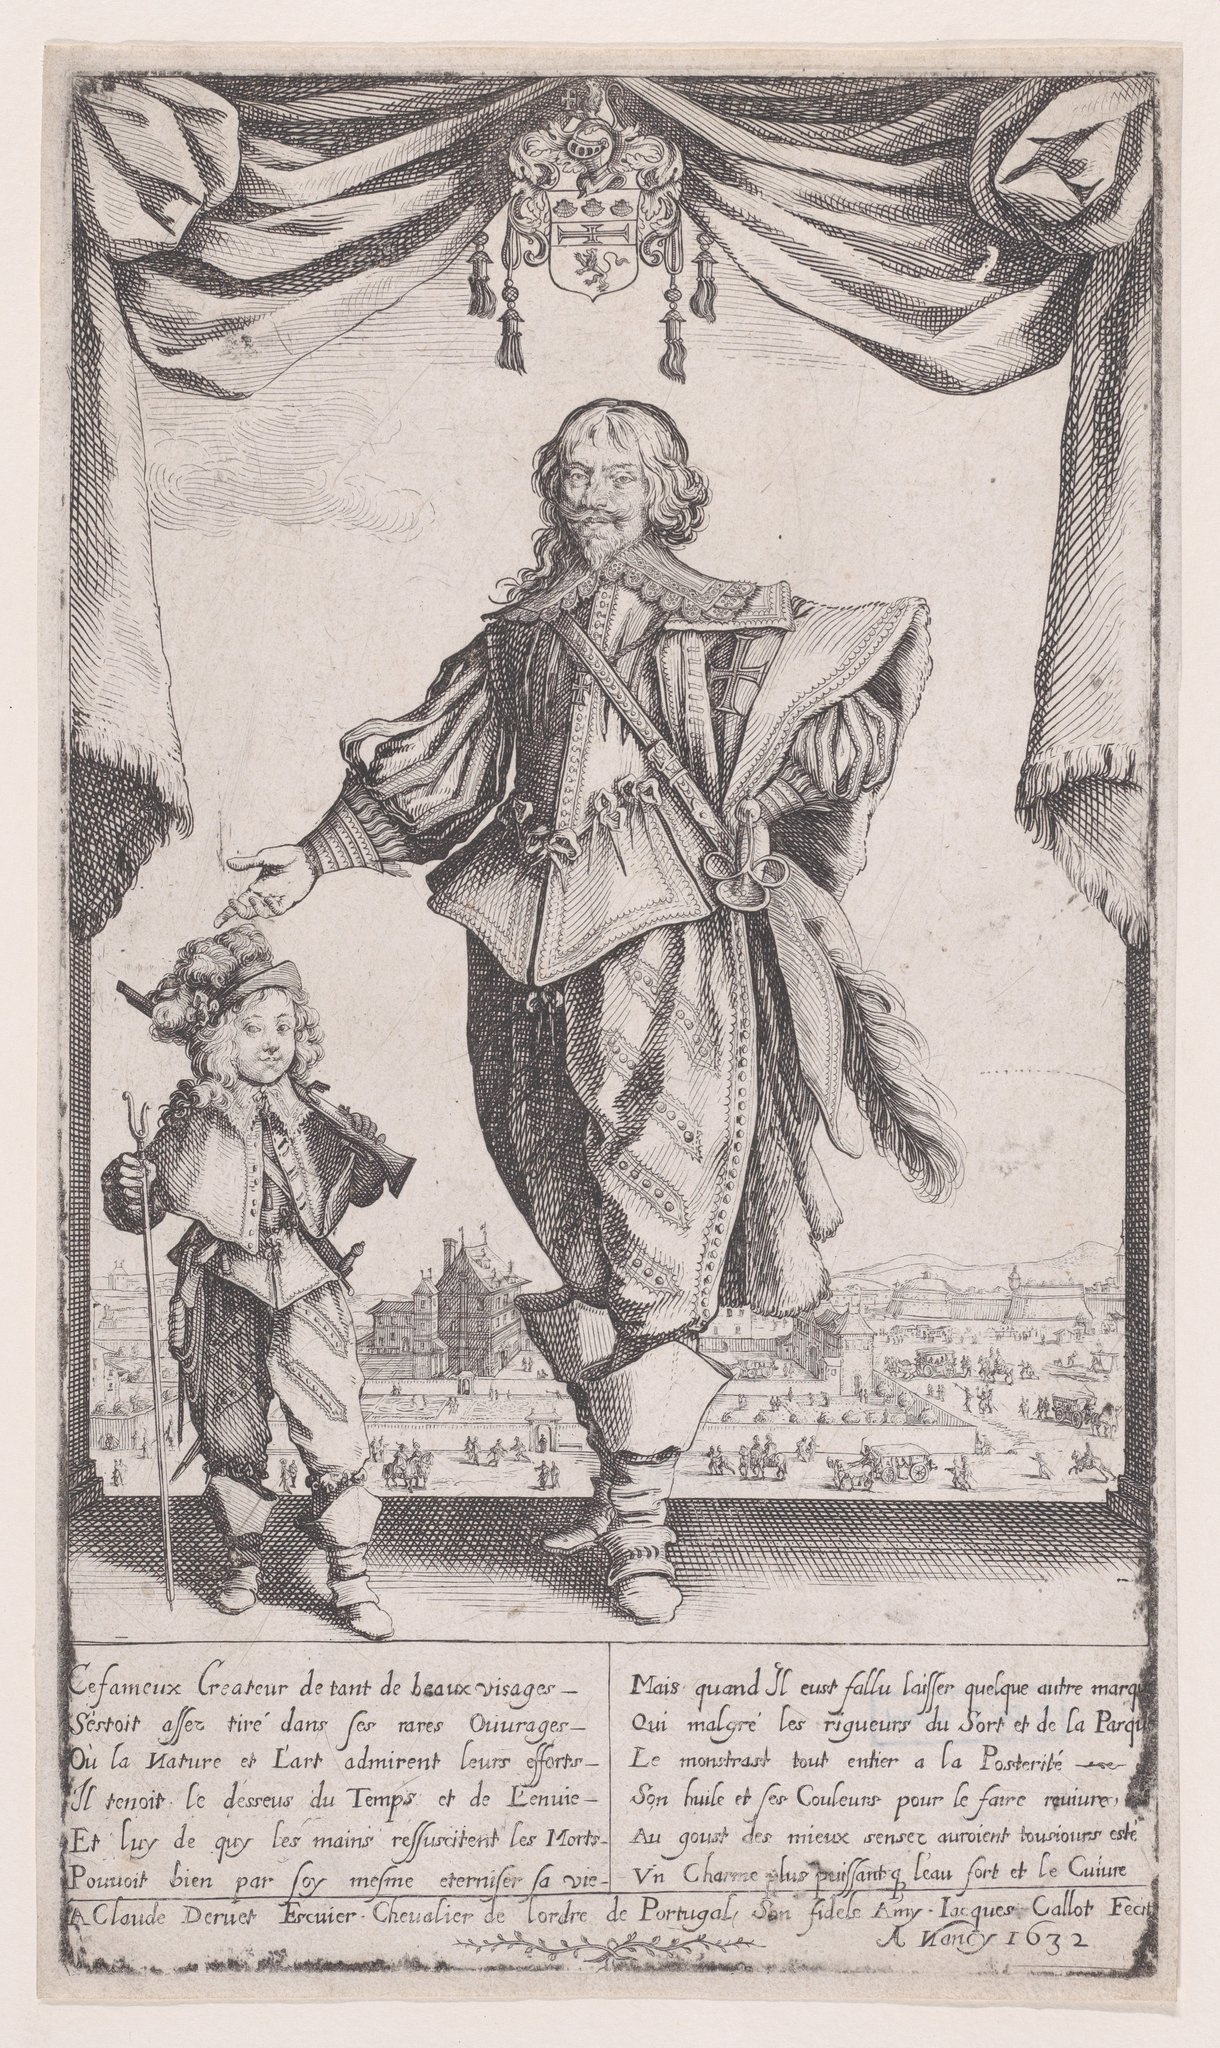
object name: print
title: Portrait of Claude Deruet and His Son, Jean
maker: jacques callot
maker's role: artist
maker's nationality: french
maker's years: 1592-1635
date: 1632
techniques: engraving, etching